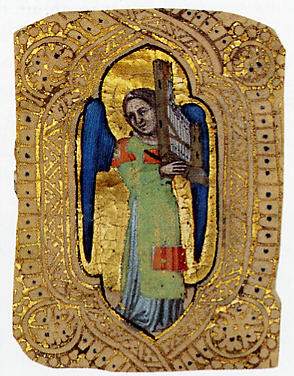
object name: manuscript and illumination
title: Angel with Portative Organ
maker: cristoforo cortese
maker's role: artist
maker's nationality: italian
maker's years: 1385-1445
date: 1401-1407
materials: gold, parchment, paint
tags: organs,angels